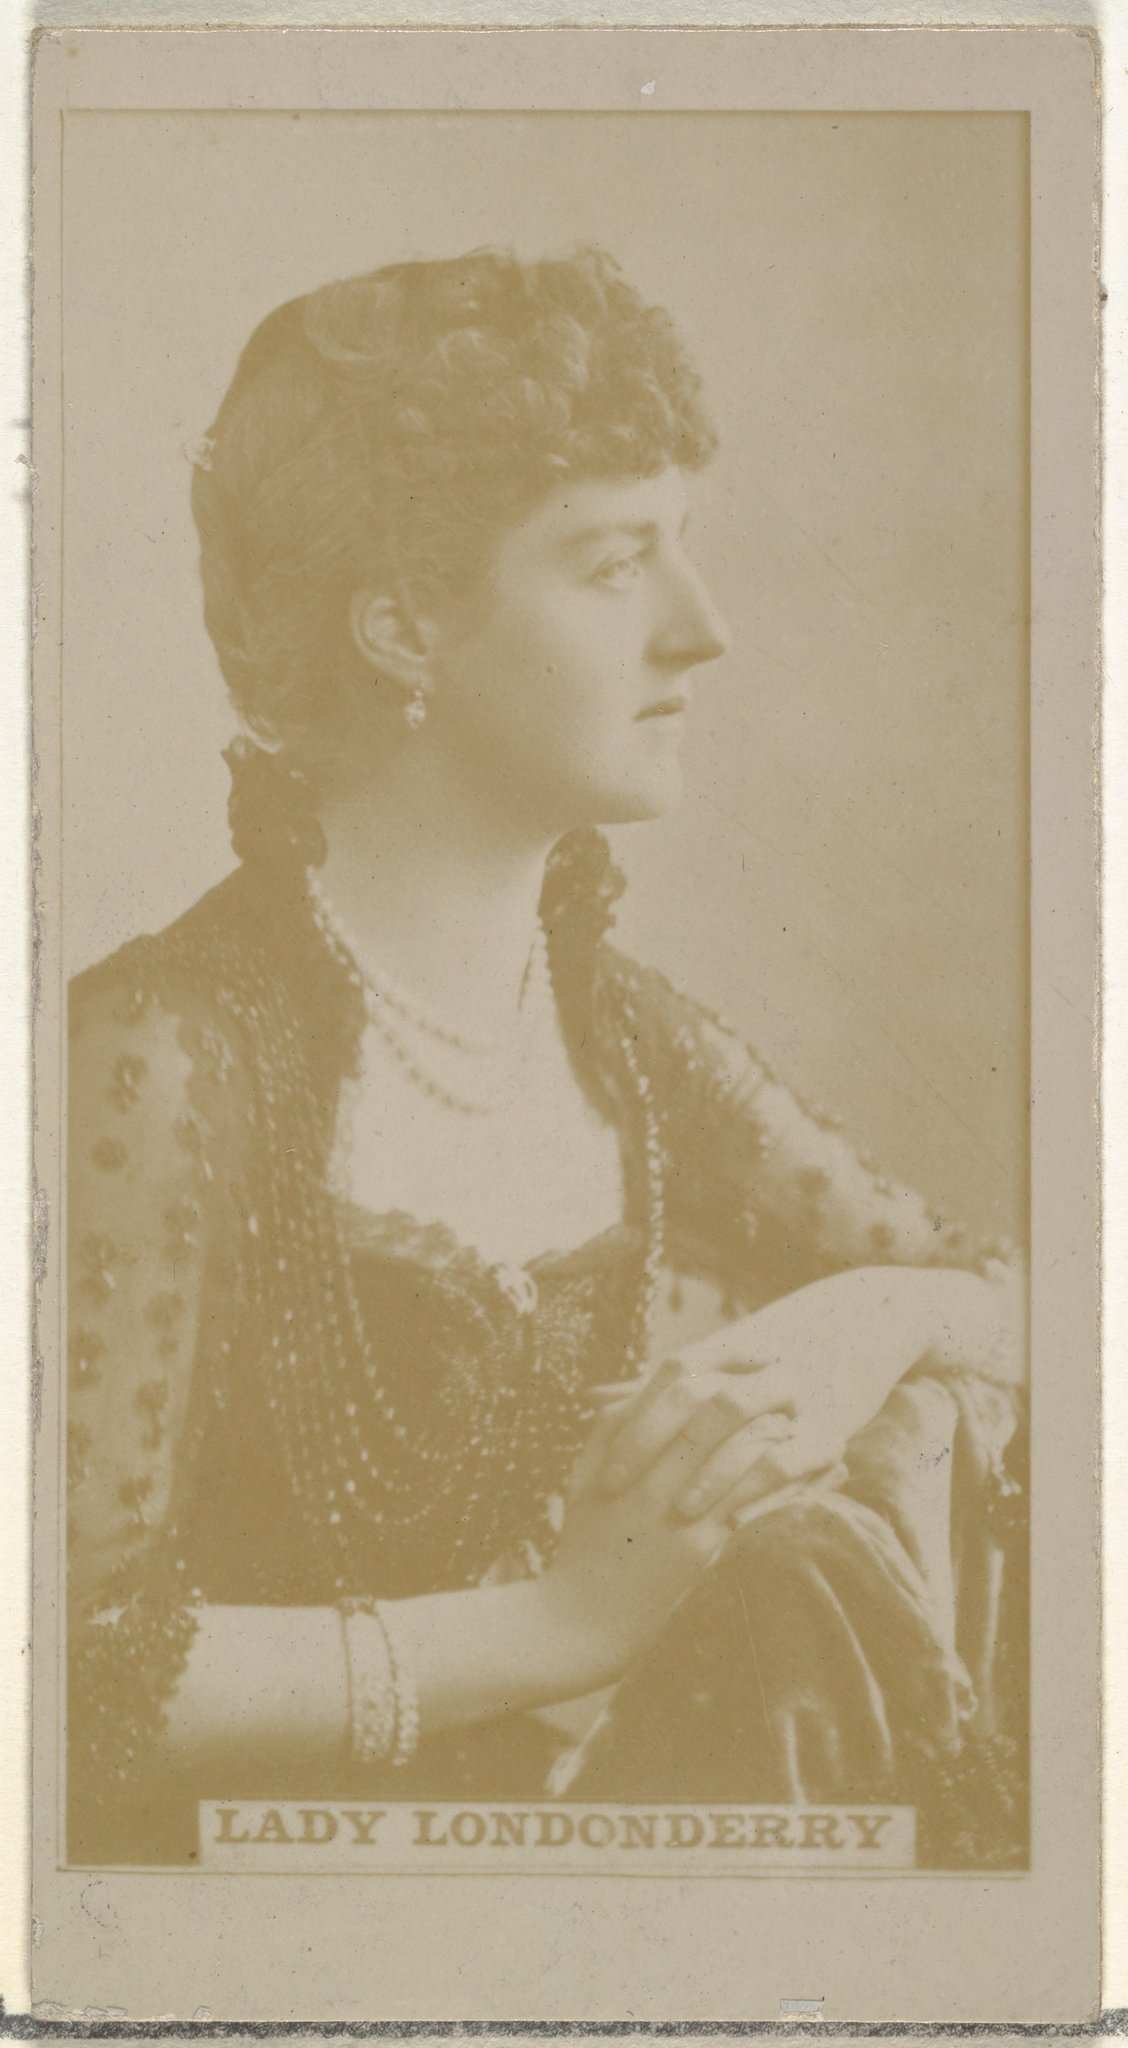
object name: photograph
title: Lady Londonberry, from the Actors and Actresses series (N145-8) issued by Duke Sons & Co. to promote Duke Cigarettes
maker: w. duke, sons & co.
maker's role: publisher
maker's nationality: american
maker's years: 1870-1920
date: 1891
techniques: albumen silver print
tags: portraits,women,actresses